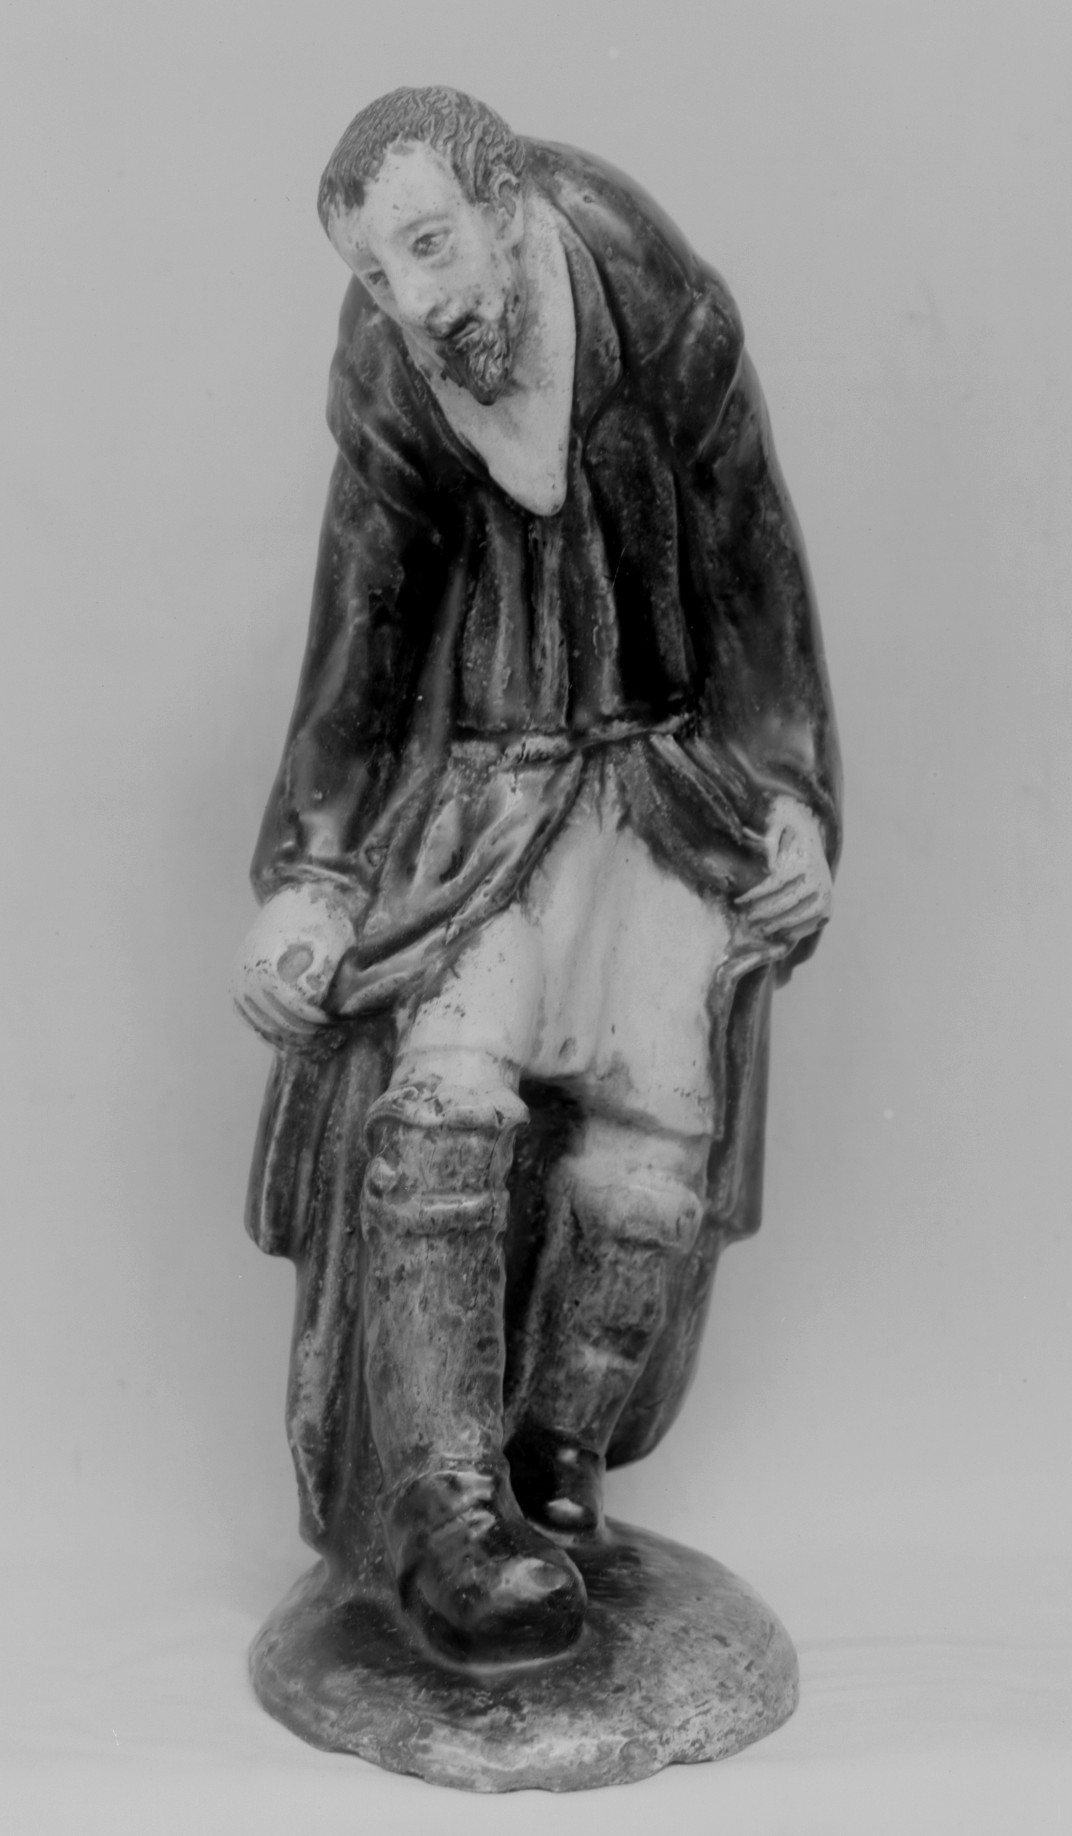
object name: figure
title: St. Roche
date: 1601-1650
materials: earthenware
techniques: glazing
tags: men,saints